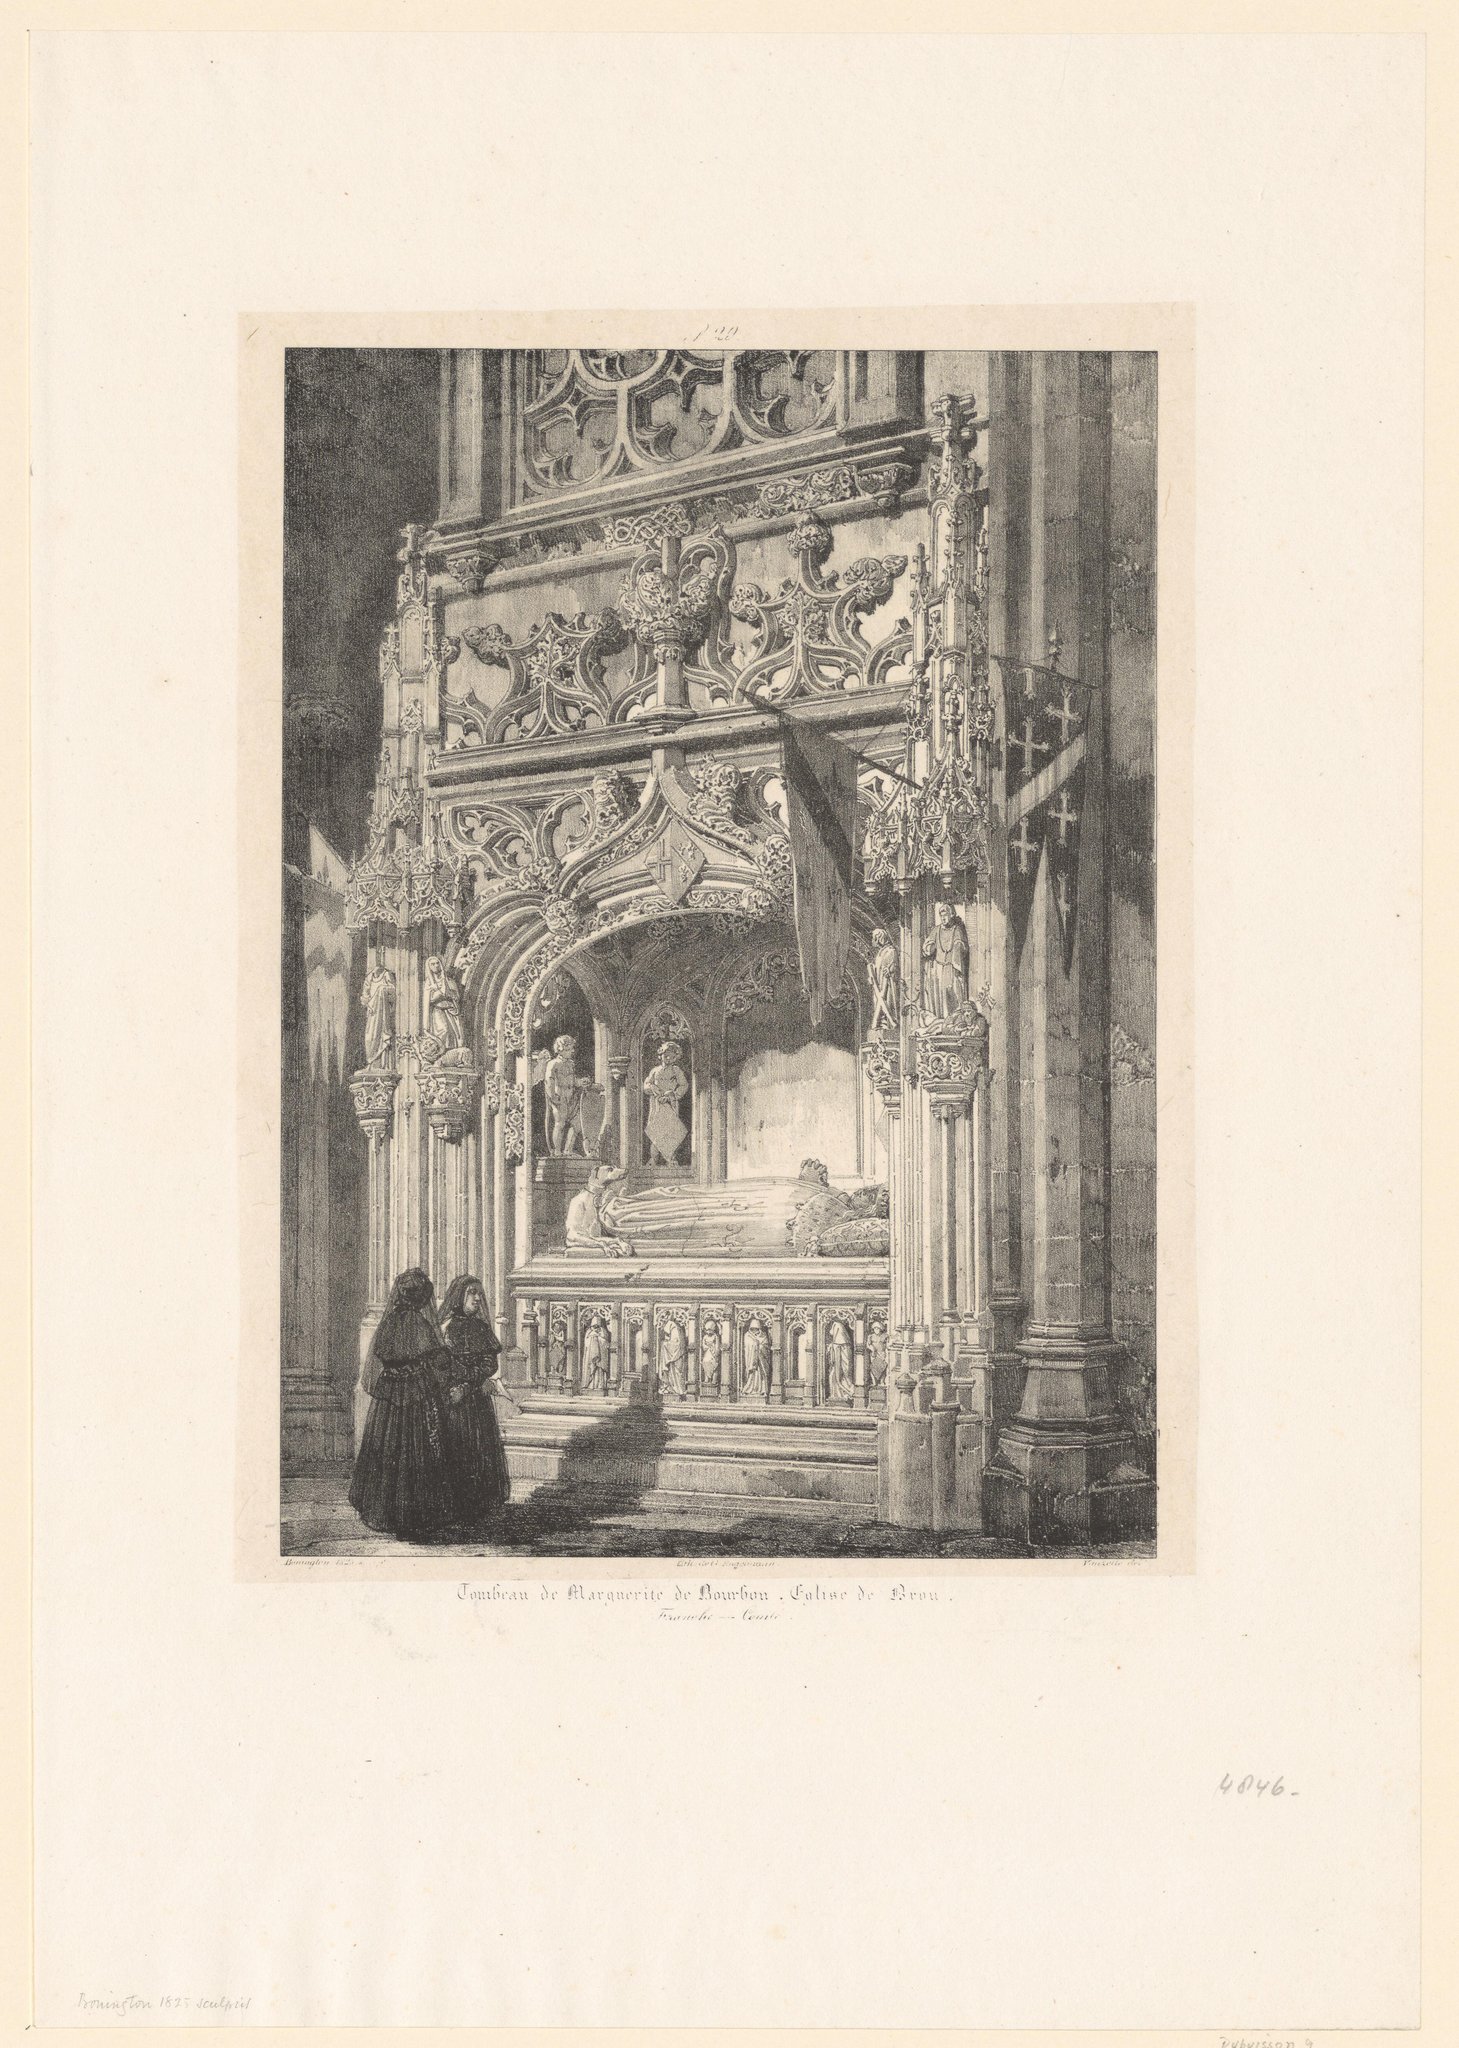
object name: print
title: Voyages pittoresques et romantiques dans l'ancienne France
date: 1825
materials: paper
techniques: lithograph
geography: paris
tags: grave, tomb, france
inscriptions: collector's mark: Lugt 2228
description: Deze prent behoort tot de serie 'Voyages pittoresques et romantiques dans l'ancienne France'. De serie is uitgevoerd onder leiding van Isidore Justin Séverin baron Taylor en bevat begeleidende teksten van Charles Nodier en Alphonse de Cailleux. Voor het project zijn vele kunstenaars naar delen van Frankrijk afgereisd. De reeks is tussen 1821 en 1878 in ca. 21 delen gepubliceerd.